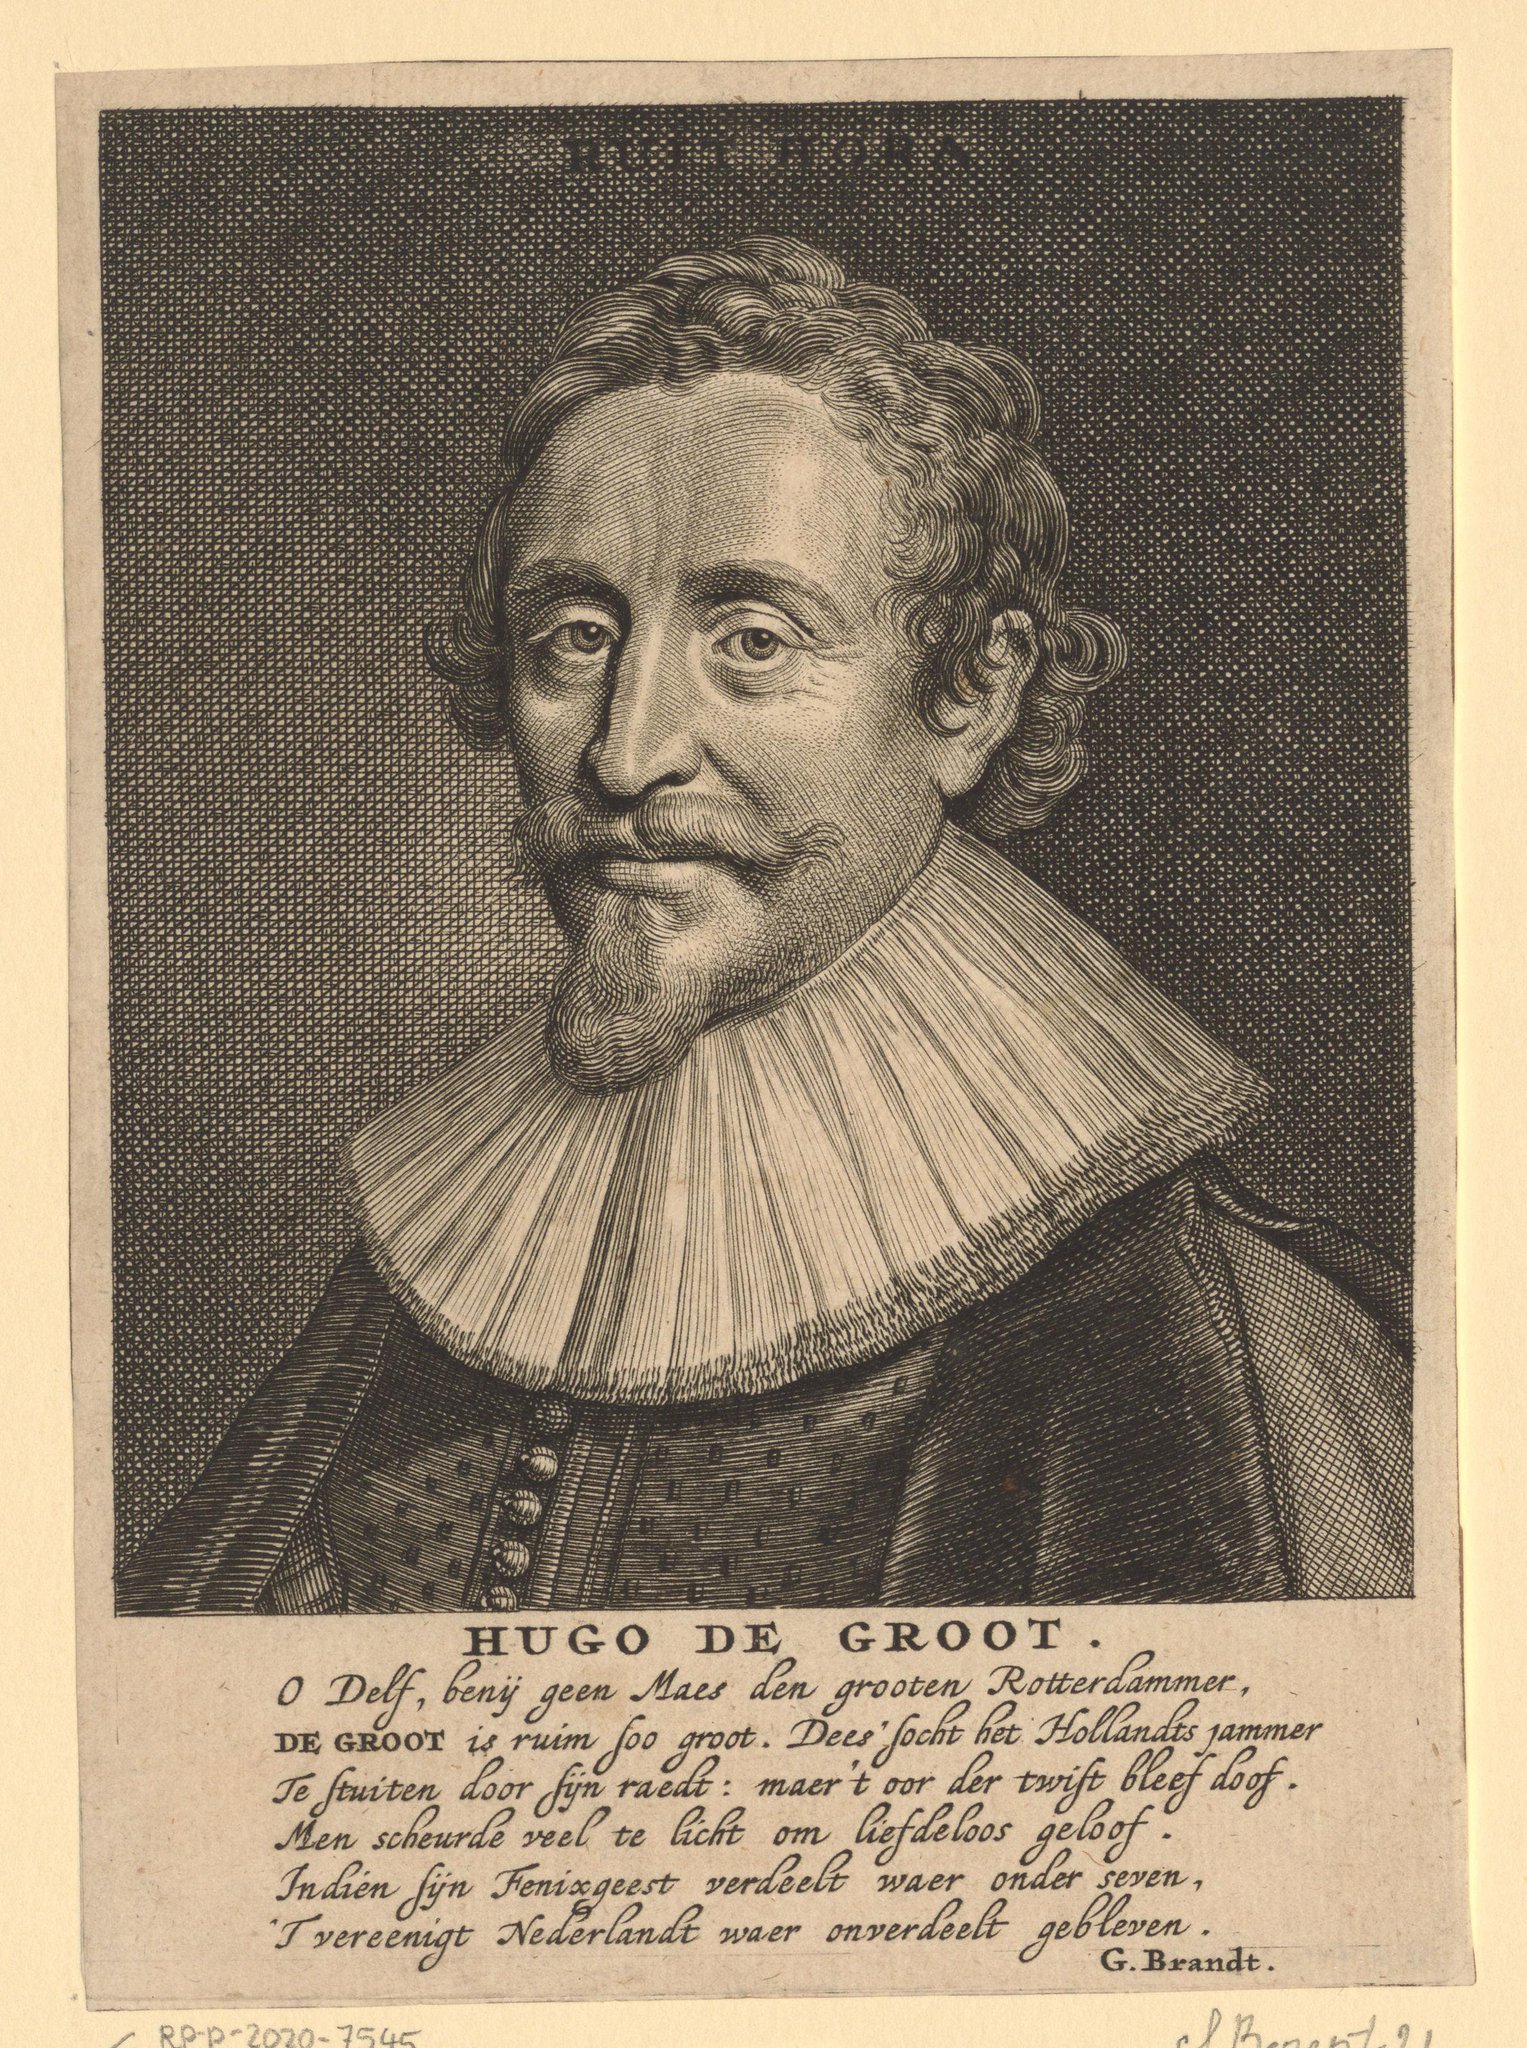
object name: book illustration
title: Portret van Hugo de Groot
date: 1674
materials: paper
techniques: engraving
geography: amsterdam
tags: delft, hugo de groot, historical persons, portrait of a writer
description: Prent uit: Geeraert (I), Brandt. Historie der Reformatie, en andre kerkelyke geschiedenissen, in en ontrent de Nederlanden. Amsterdam: Jan Rieuwertsz. (I) en Hendrik en Dirk Boom, 1674, dl. 2, p. 798.